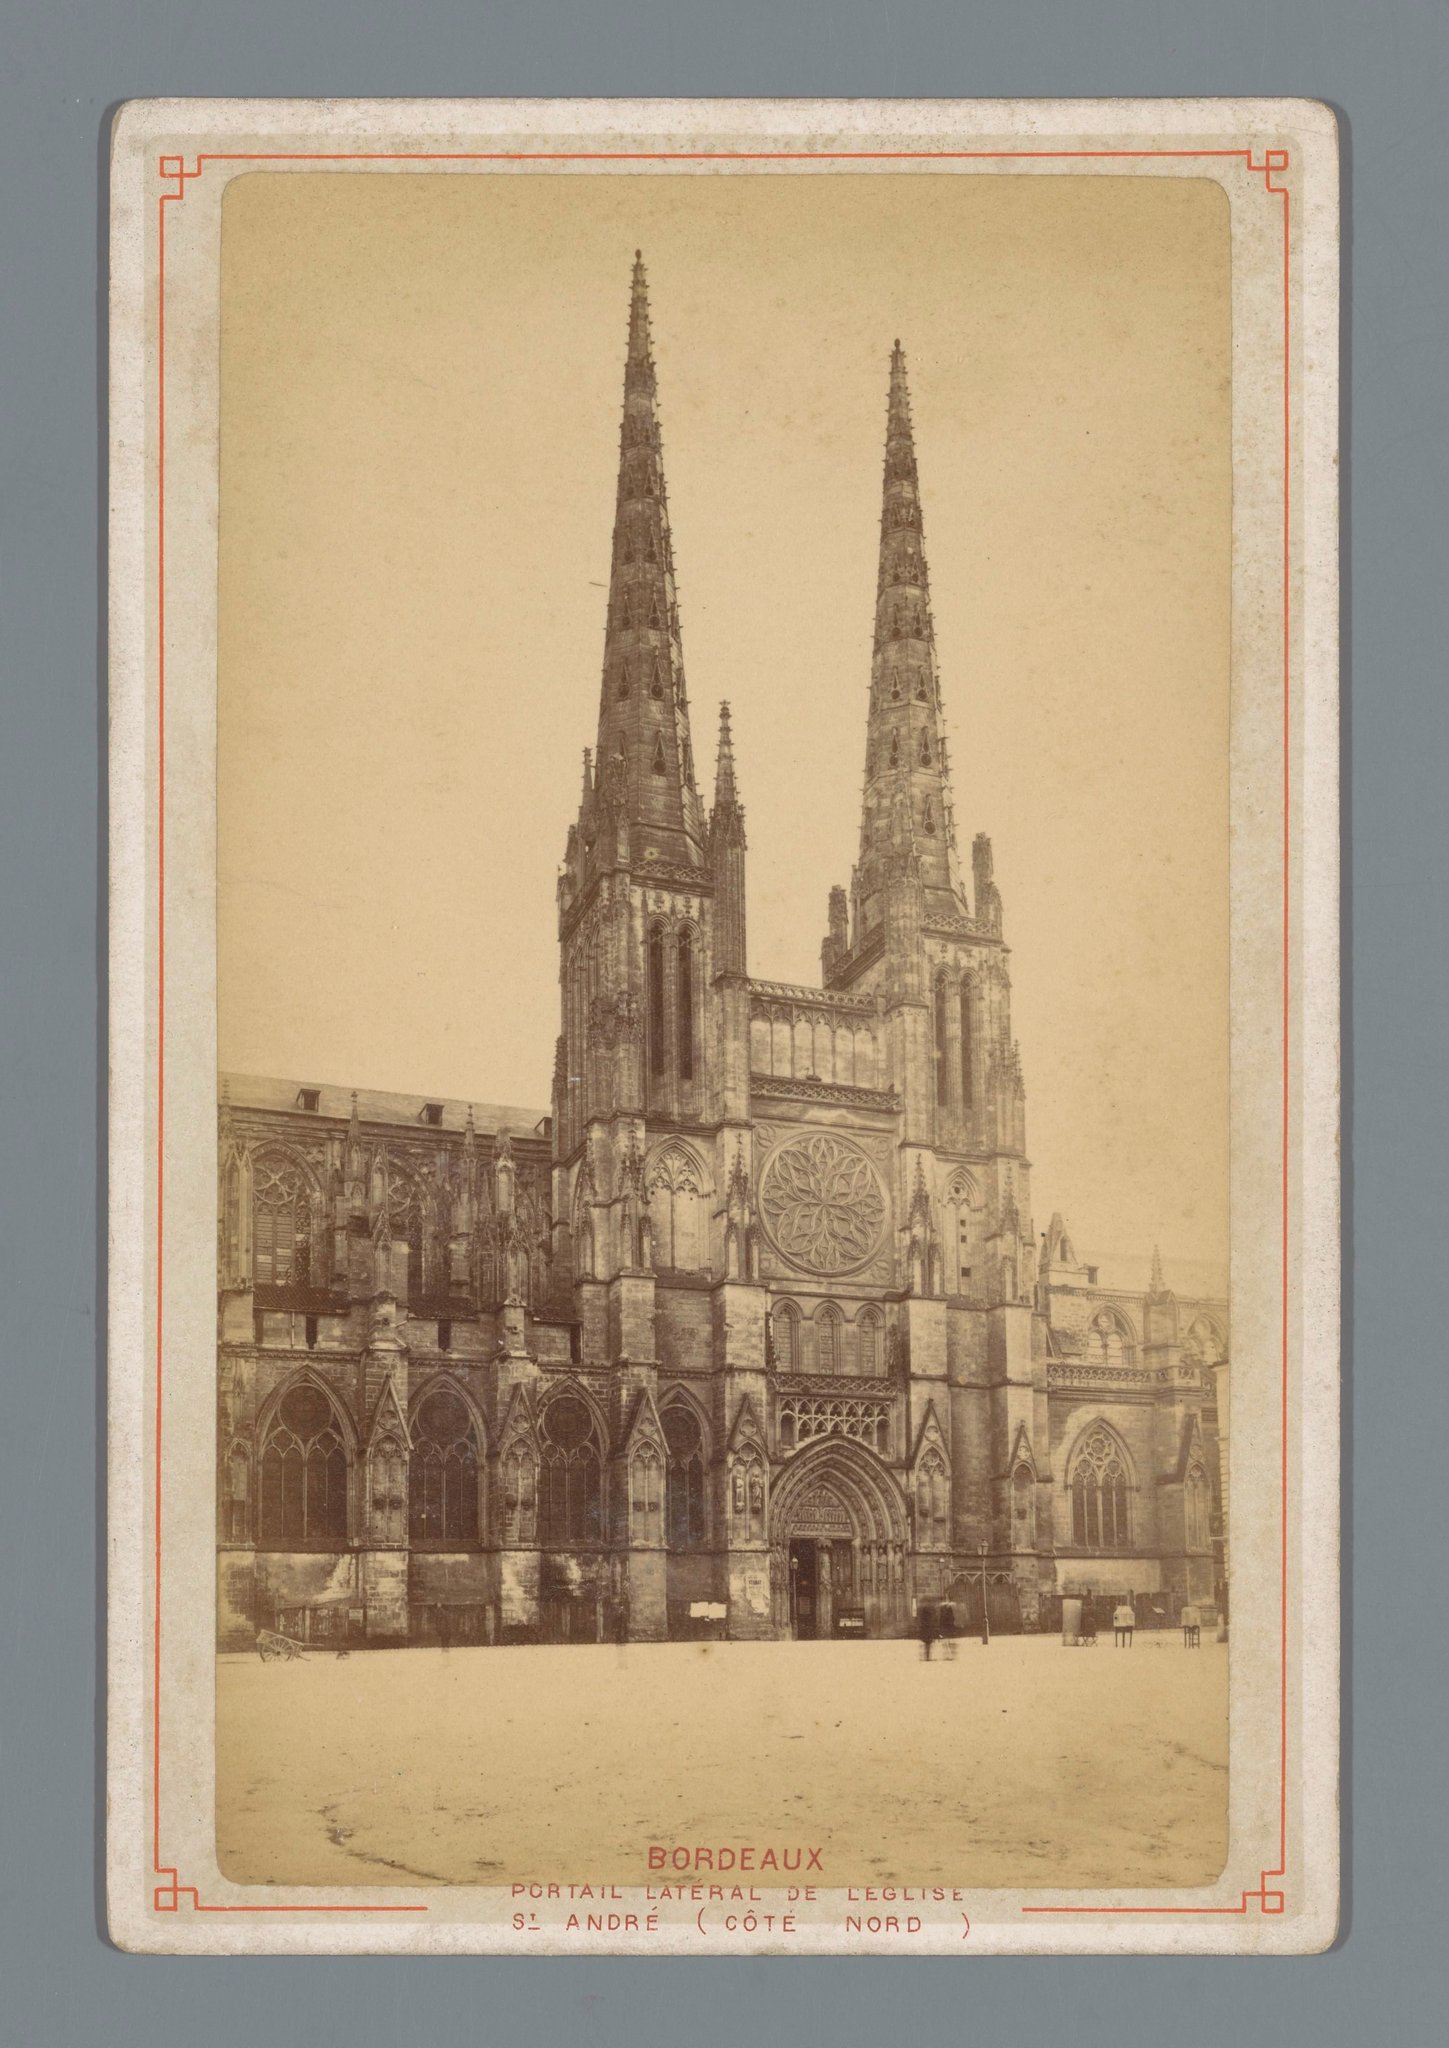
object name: cabinet photograph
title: Gezicht op de kathedraal van Bordeaux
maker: Anonymous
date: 1870-1900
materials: cardboard, photographic support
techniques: albumen print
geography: bordeaux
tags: church (exterior), façade (of house or building)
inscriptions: retailer's mark: ‘PAPETERIE/ JOININ BRIOL/ BORDEAUX/ Rue Ste-Catherine, 25’